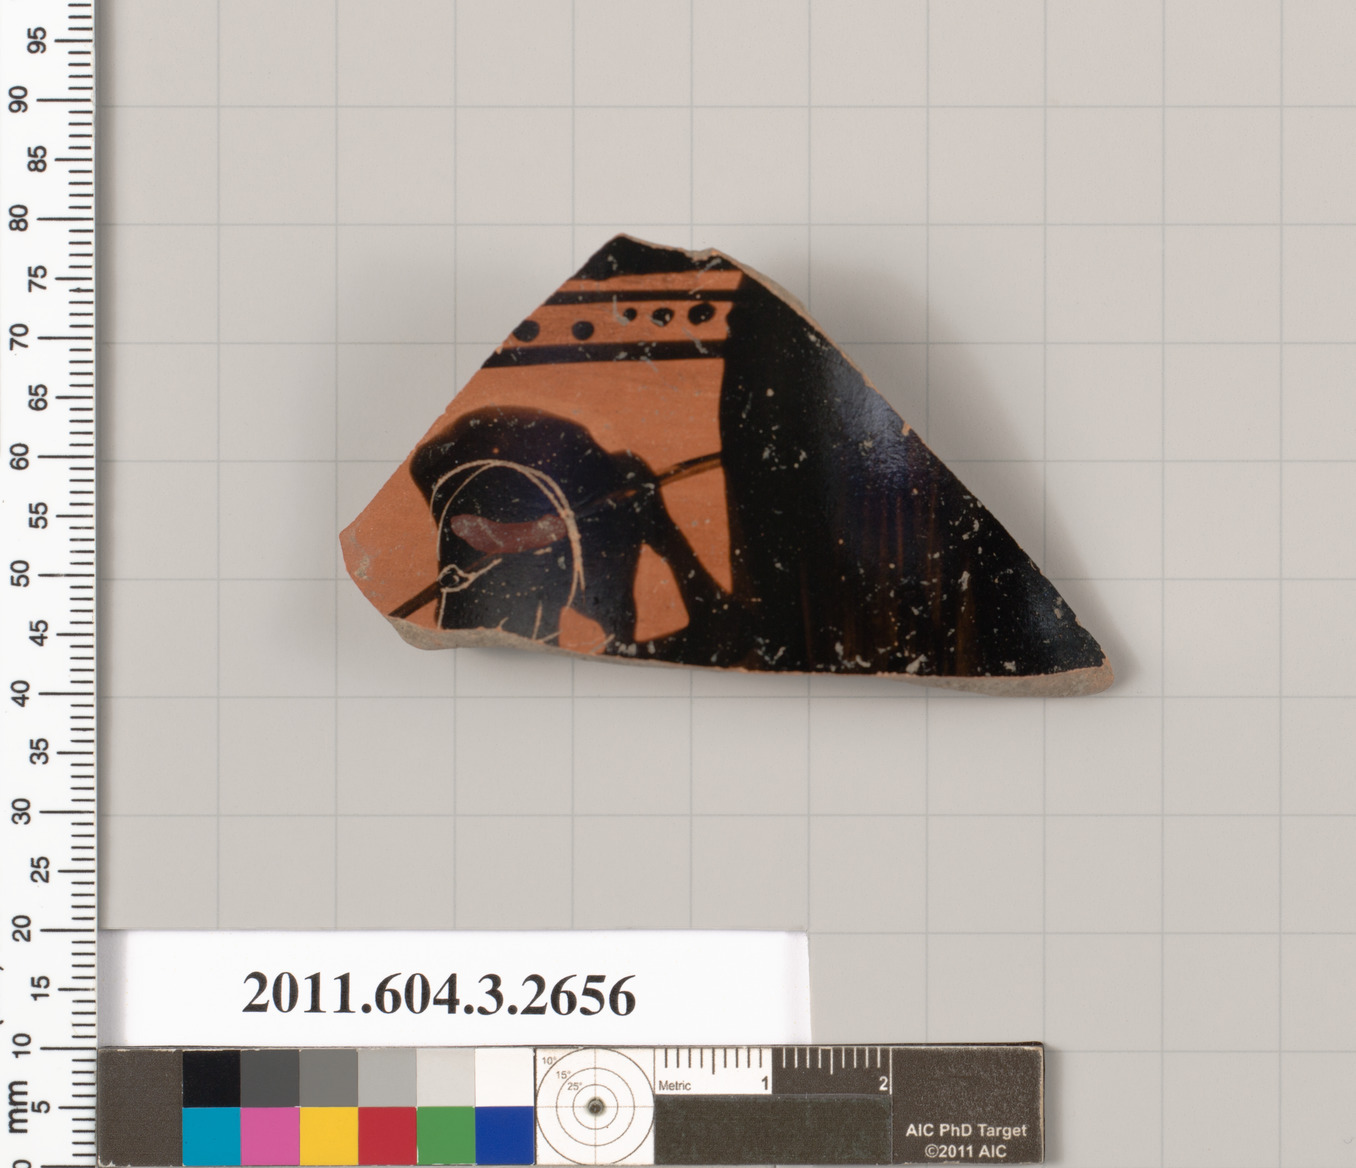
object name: olpe fragment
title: Terracotta fragment of an olpe (jug)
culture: greek, attic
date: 534-468 BCE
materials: terracotta